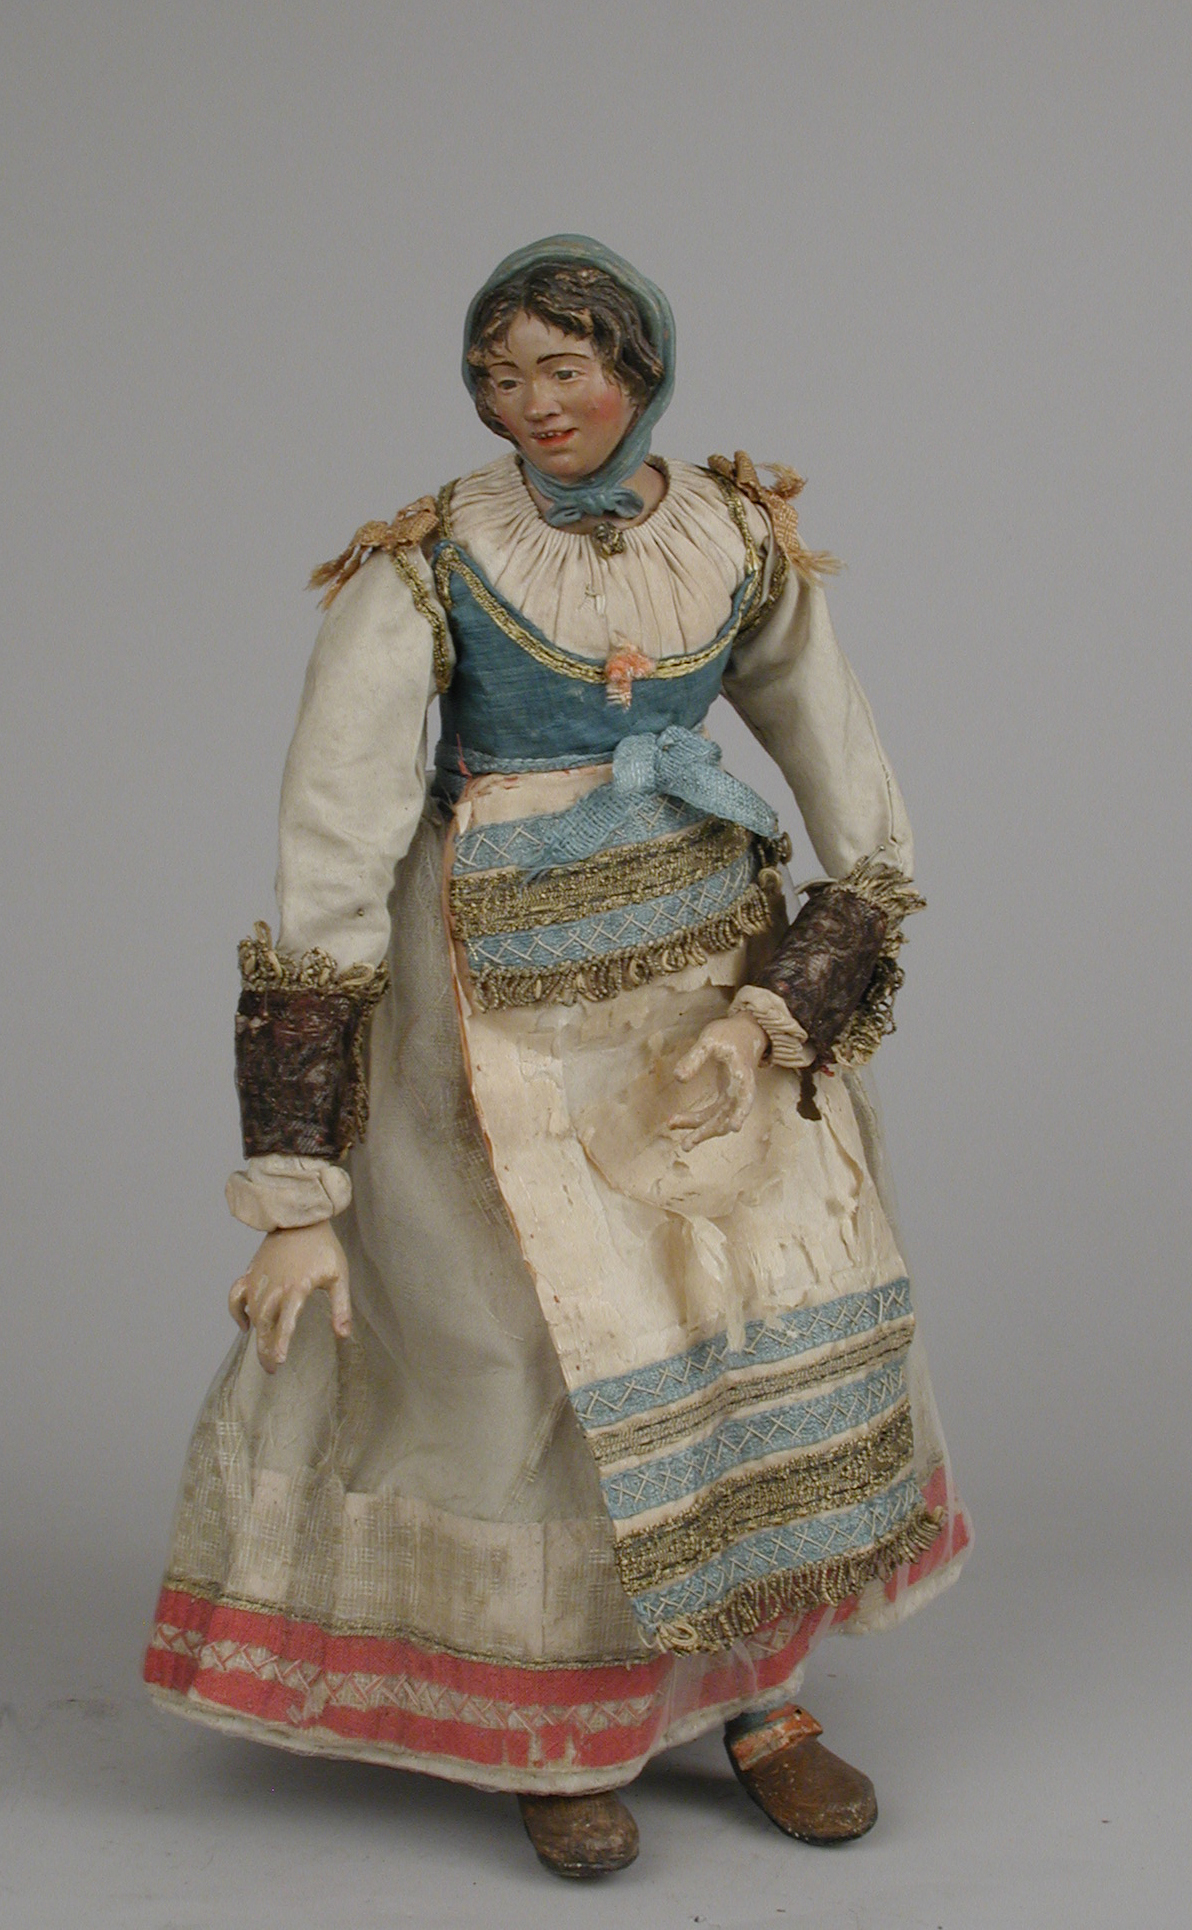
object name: crèche figure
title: Young peasant woman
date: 1790-1820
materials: glass, linen, silk, terracotta, fiber, metal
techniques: polychrome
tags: women